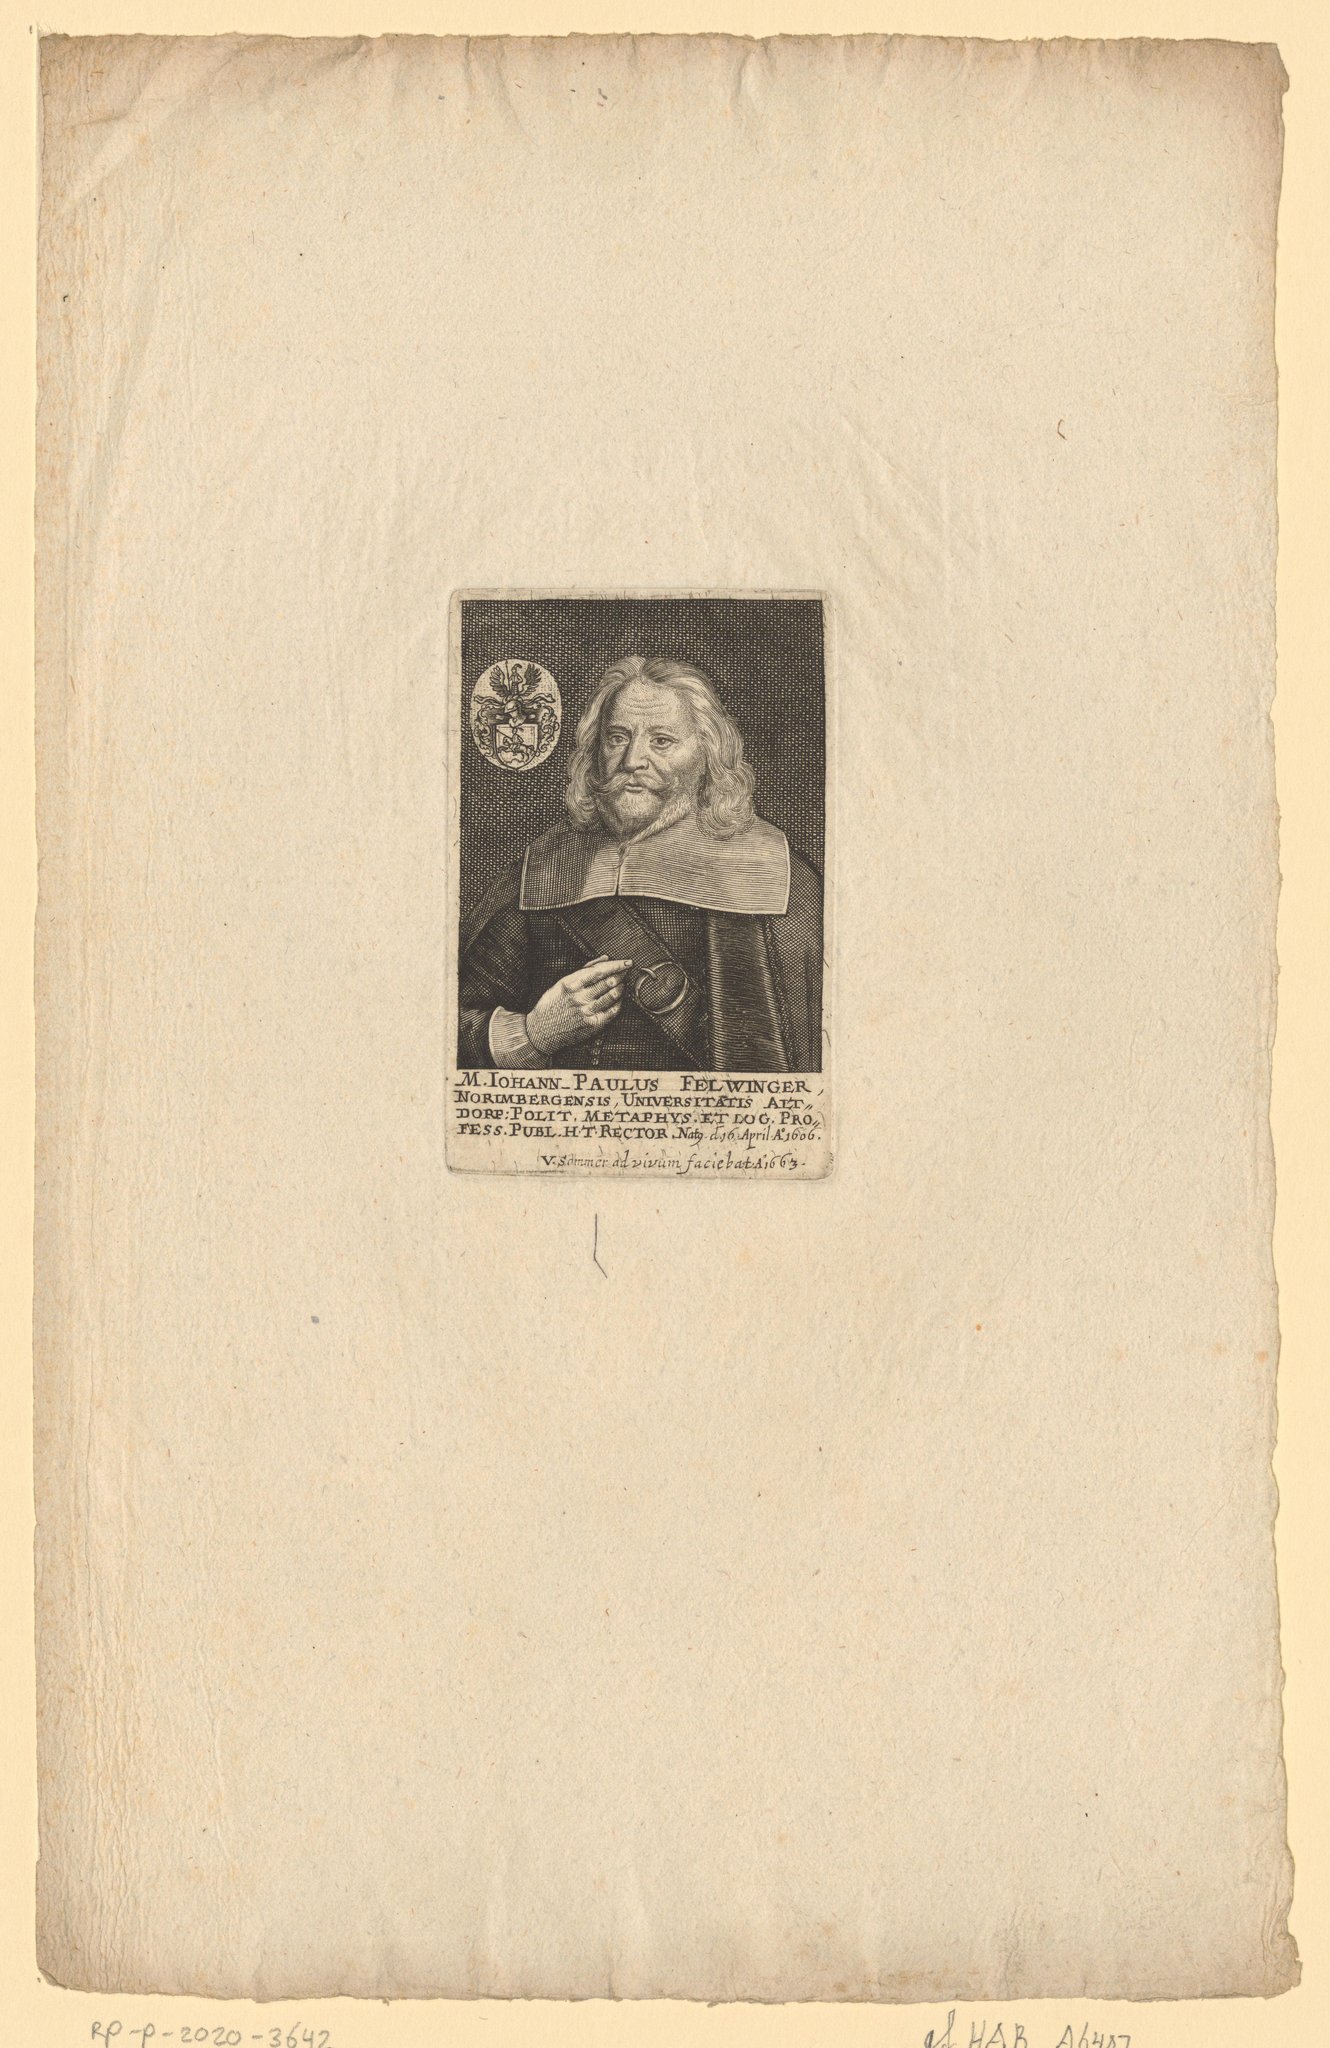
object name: print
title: Portret van Johann Paul Felwinger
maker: matthias van sommer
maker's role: draughtsman, print maker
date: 1663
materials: paper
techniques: engraving, etching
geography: germany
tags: historical persons, armorial bearing, heraldry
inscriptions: date